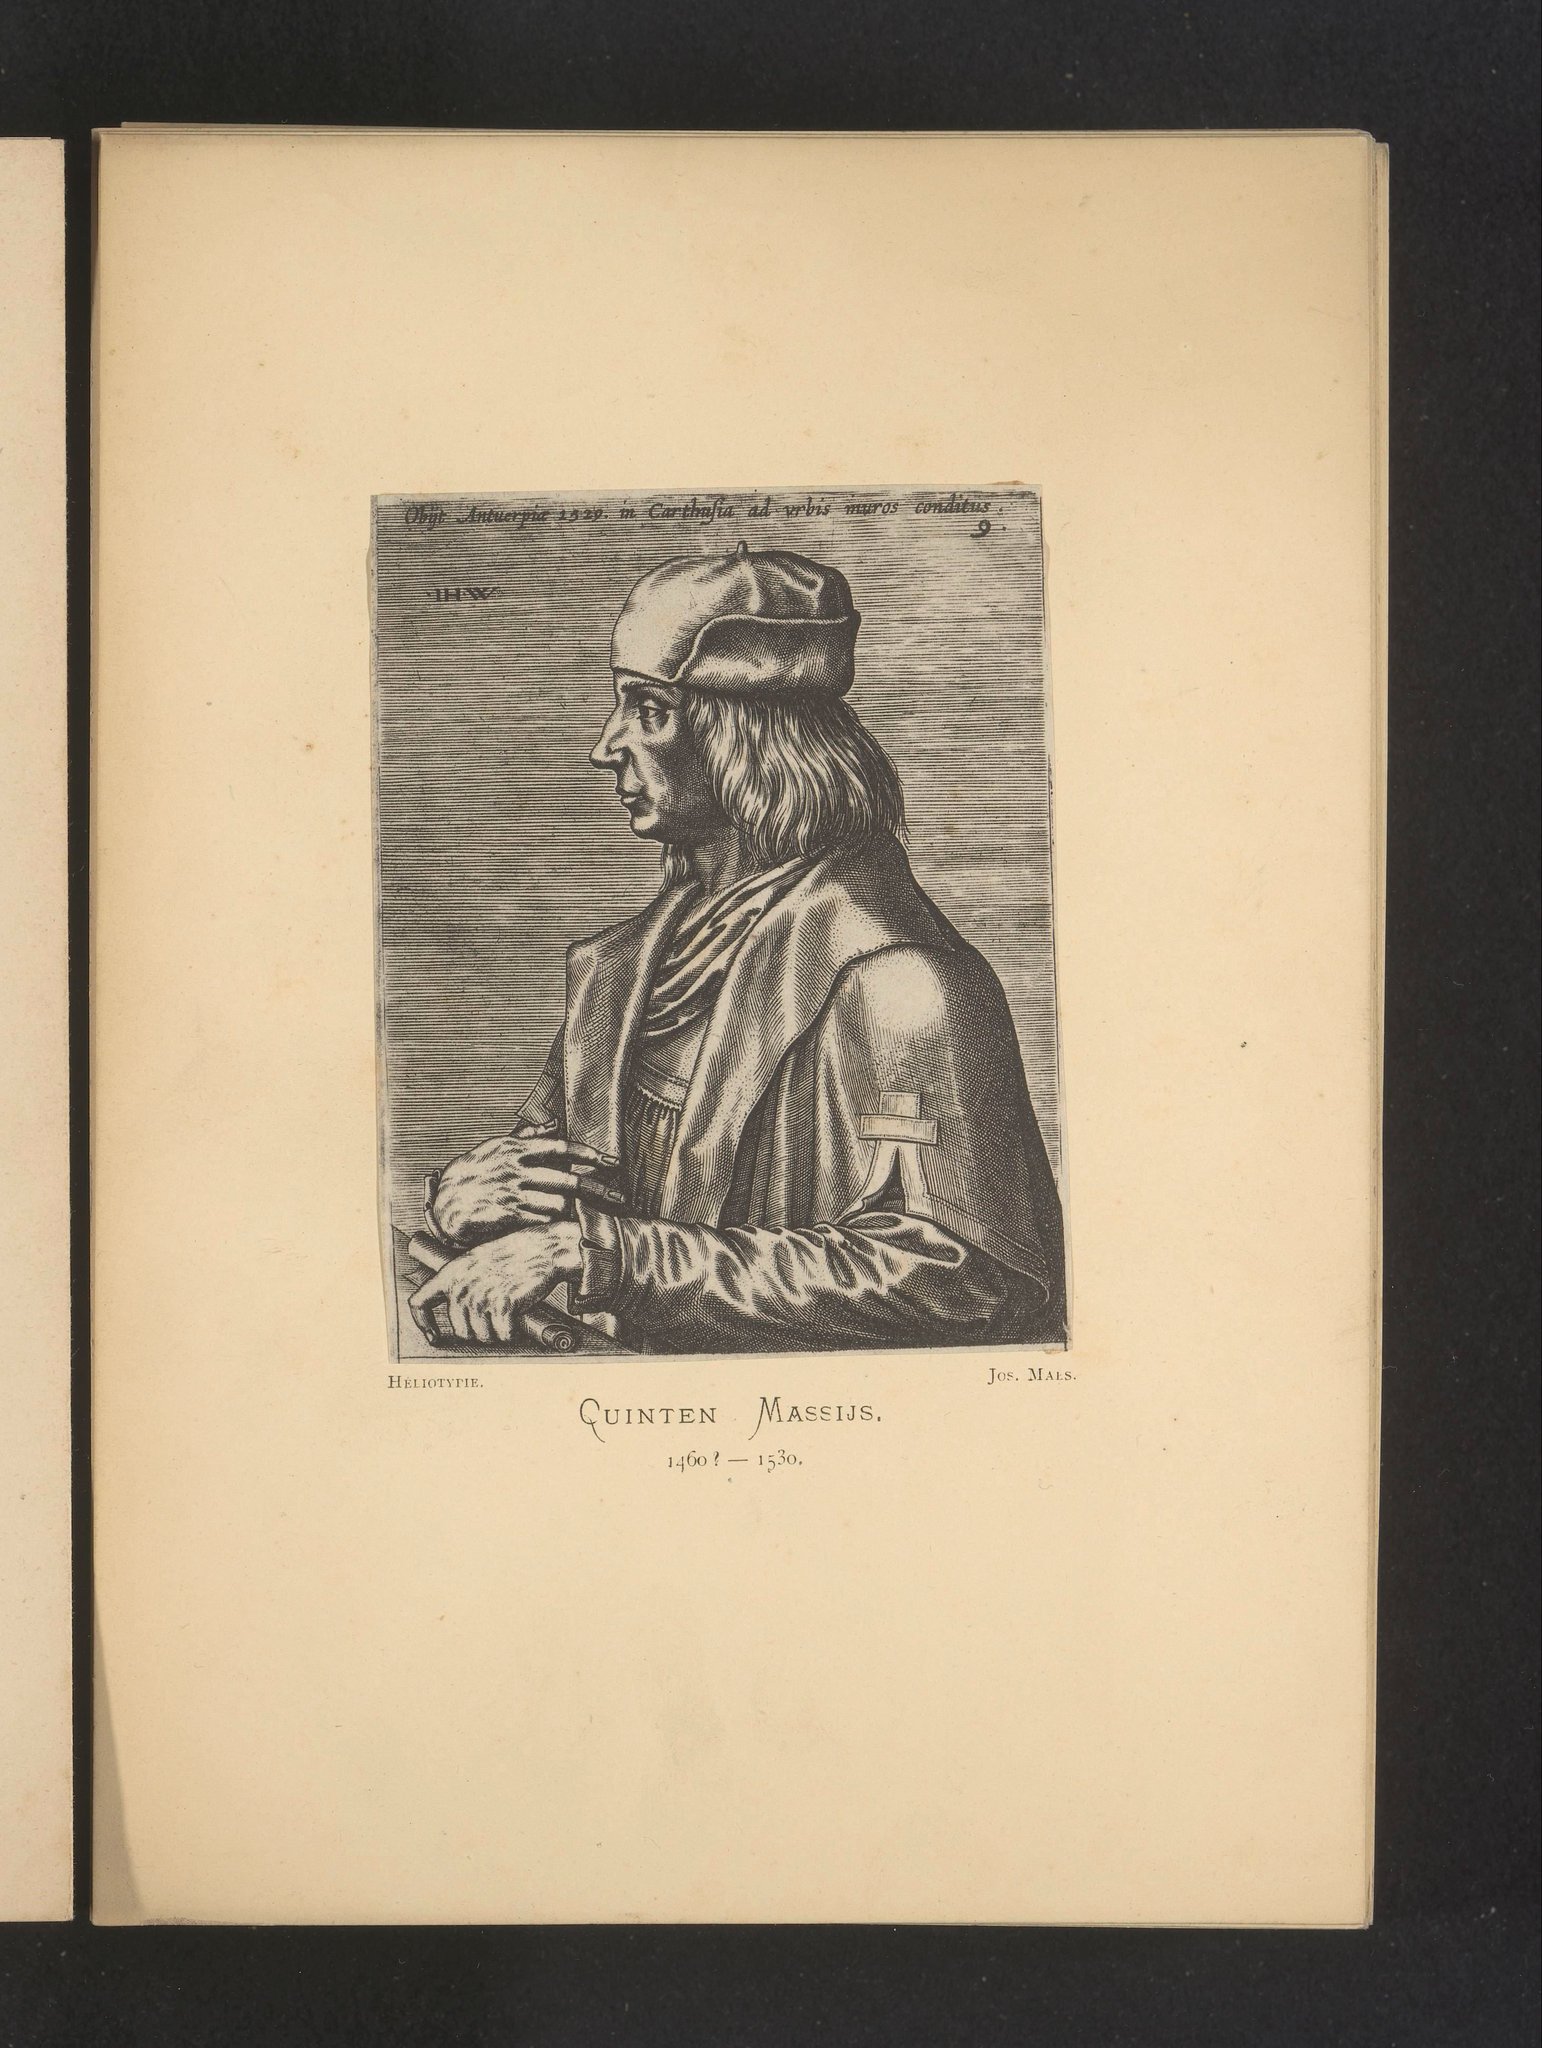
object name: photomechanical print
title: Quinten Massijs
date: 1872-1877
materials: cardboard, paper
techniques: photograph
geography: antwerp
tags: louvain, antwerp, painter, draughtsman, quinten massijs (i), historical persons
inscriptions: inscription: ‘1460? - 1530.’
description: Deze prent maakt deel uit van een omslag met 150 prenten en een katern met een lijst van afbeeldingen.